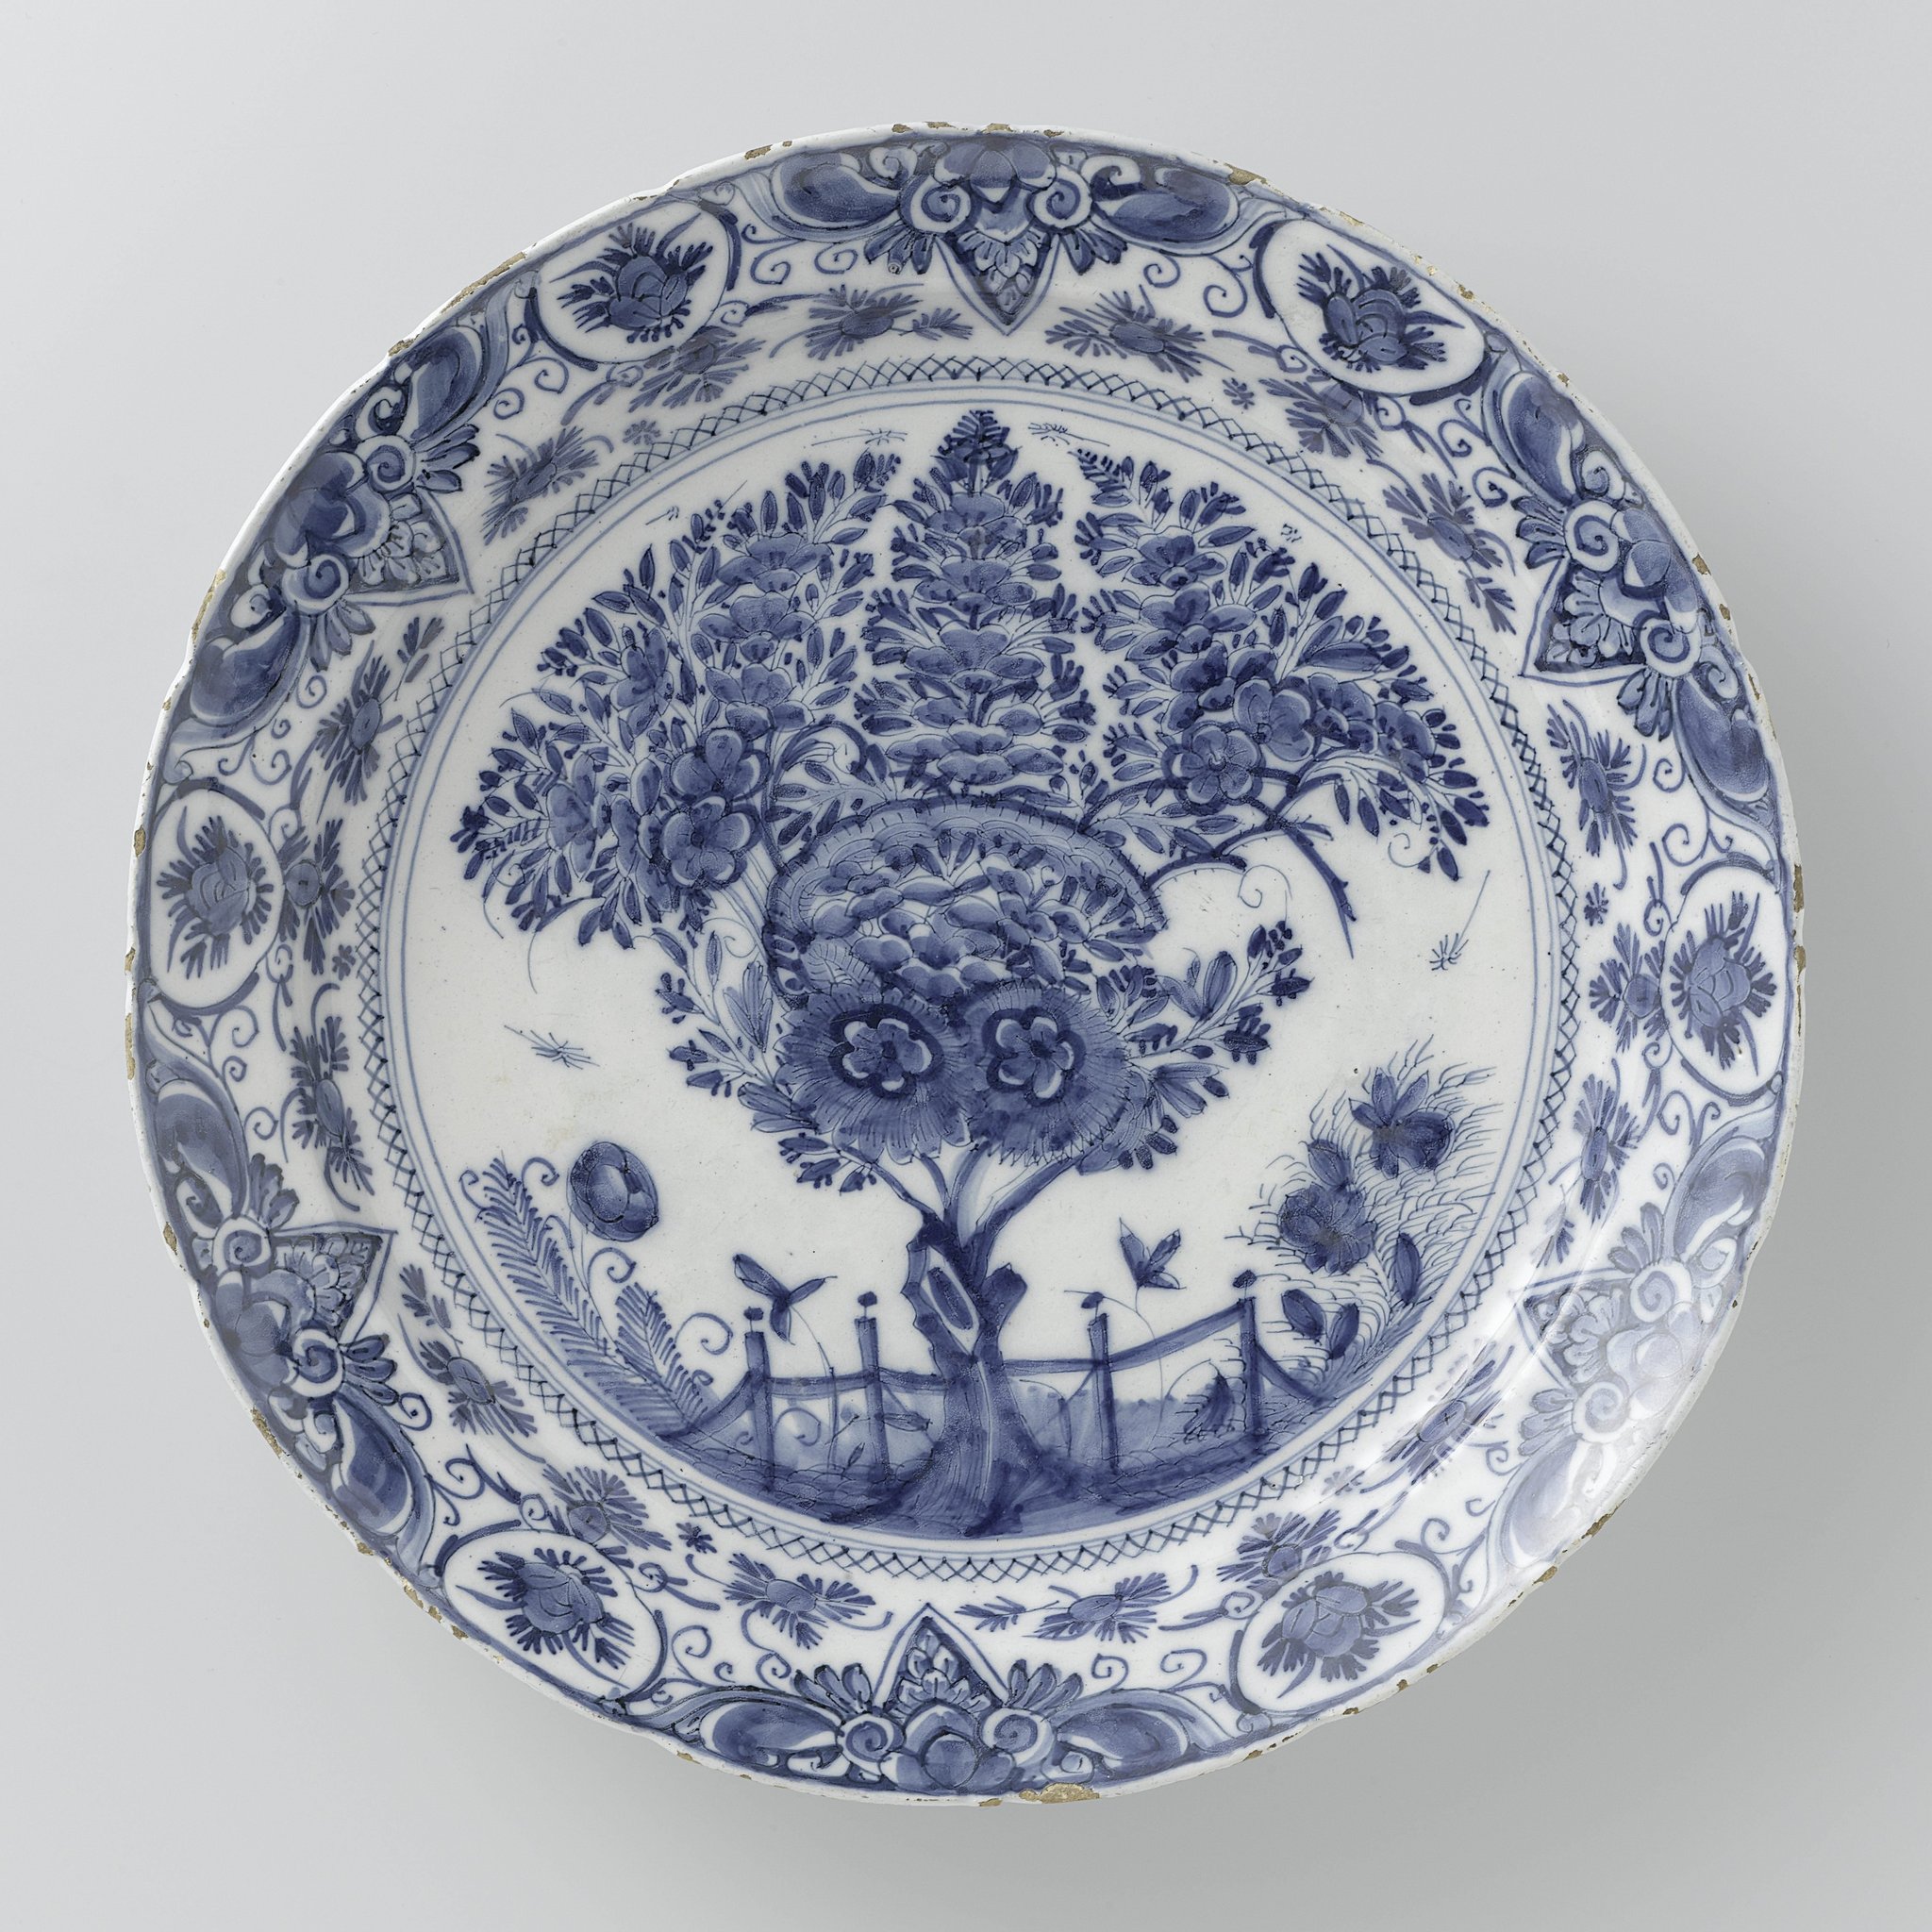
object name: platter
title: Schotel van faïence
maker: cornelis brouwer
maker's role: print maker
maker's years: 1731-1803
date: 1725-1750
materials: earthenware, glaze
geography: delft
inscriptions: mark: ‘CB./ figuratief teken ster’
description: Schotel van faience. Blauw beschilderd met een fantasie-boom.